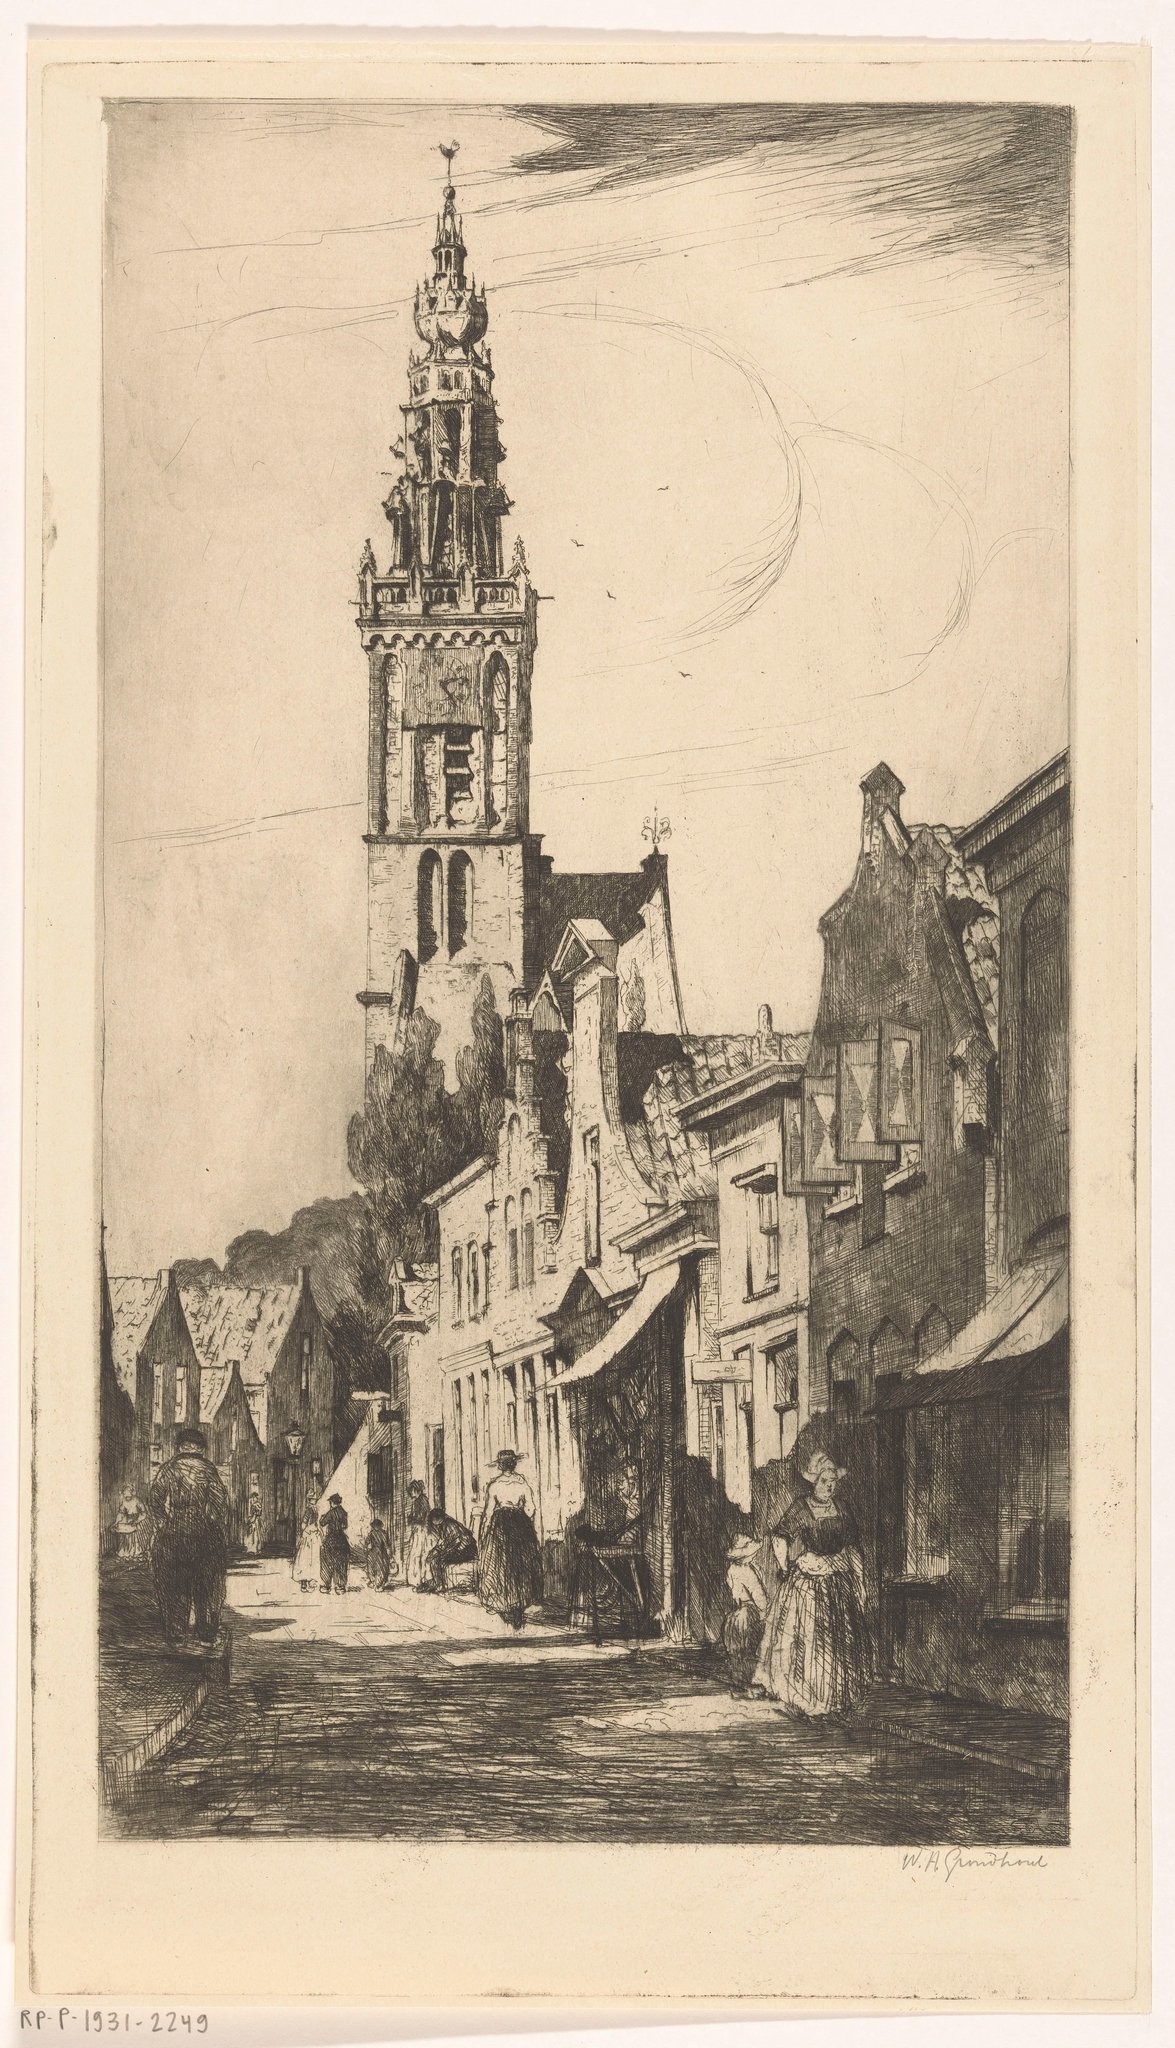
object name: print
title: Stadhuistoren Veere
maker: willem adrianus grondhout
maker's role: draughtsman, painter, print maker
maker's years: 1878-1934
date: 1888-1931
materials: paper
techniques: etching, intaglio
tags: street, parts of church exterior and annexes: tower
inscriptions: collector's mark: Lugt 2228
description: De Speeltoren, de toren van de voormalige Onze Lieve Vrouwekerk, gezien vanaf de Lingerzijde in Edam.